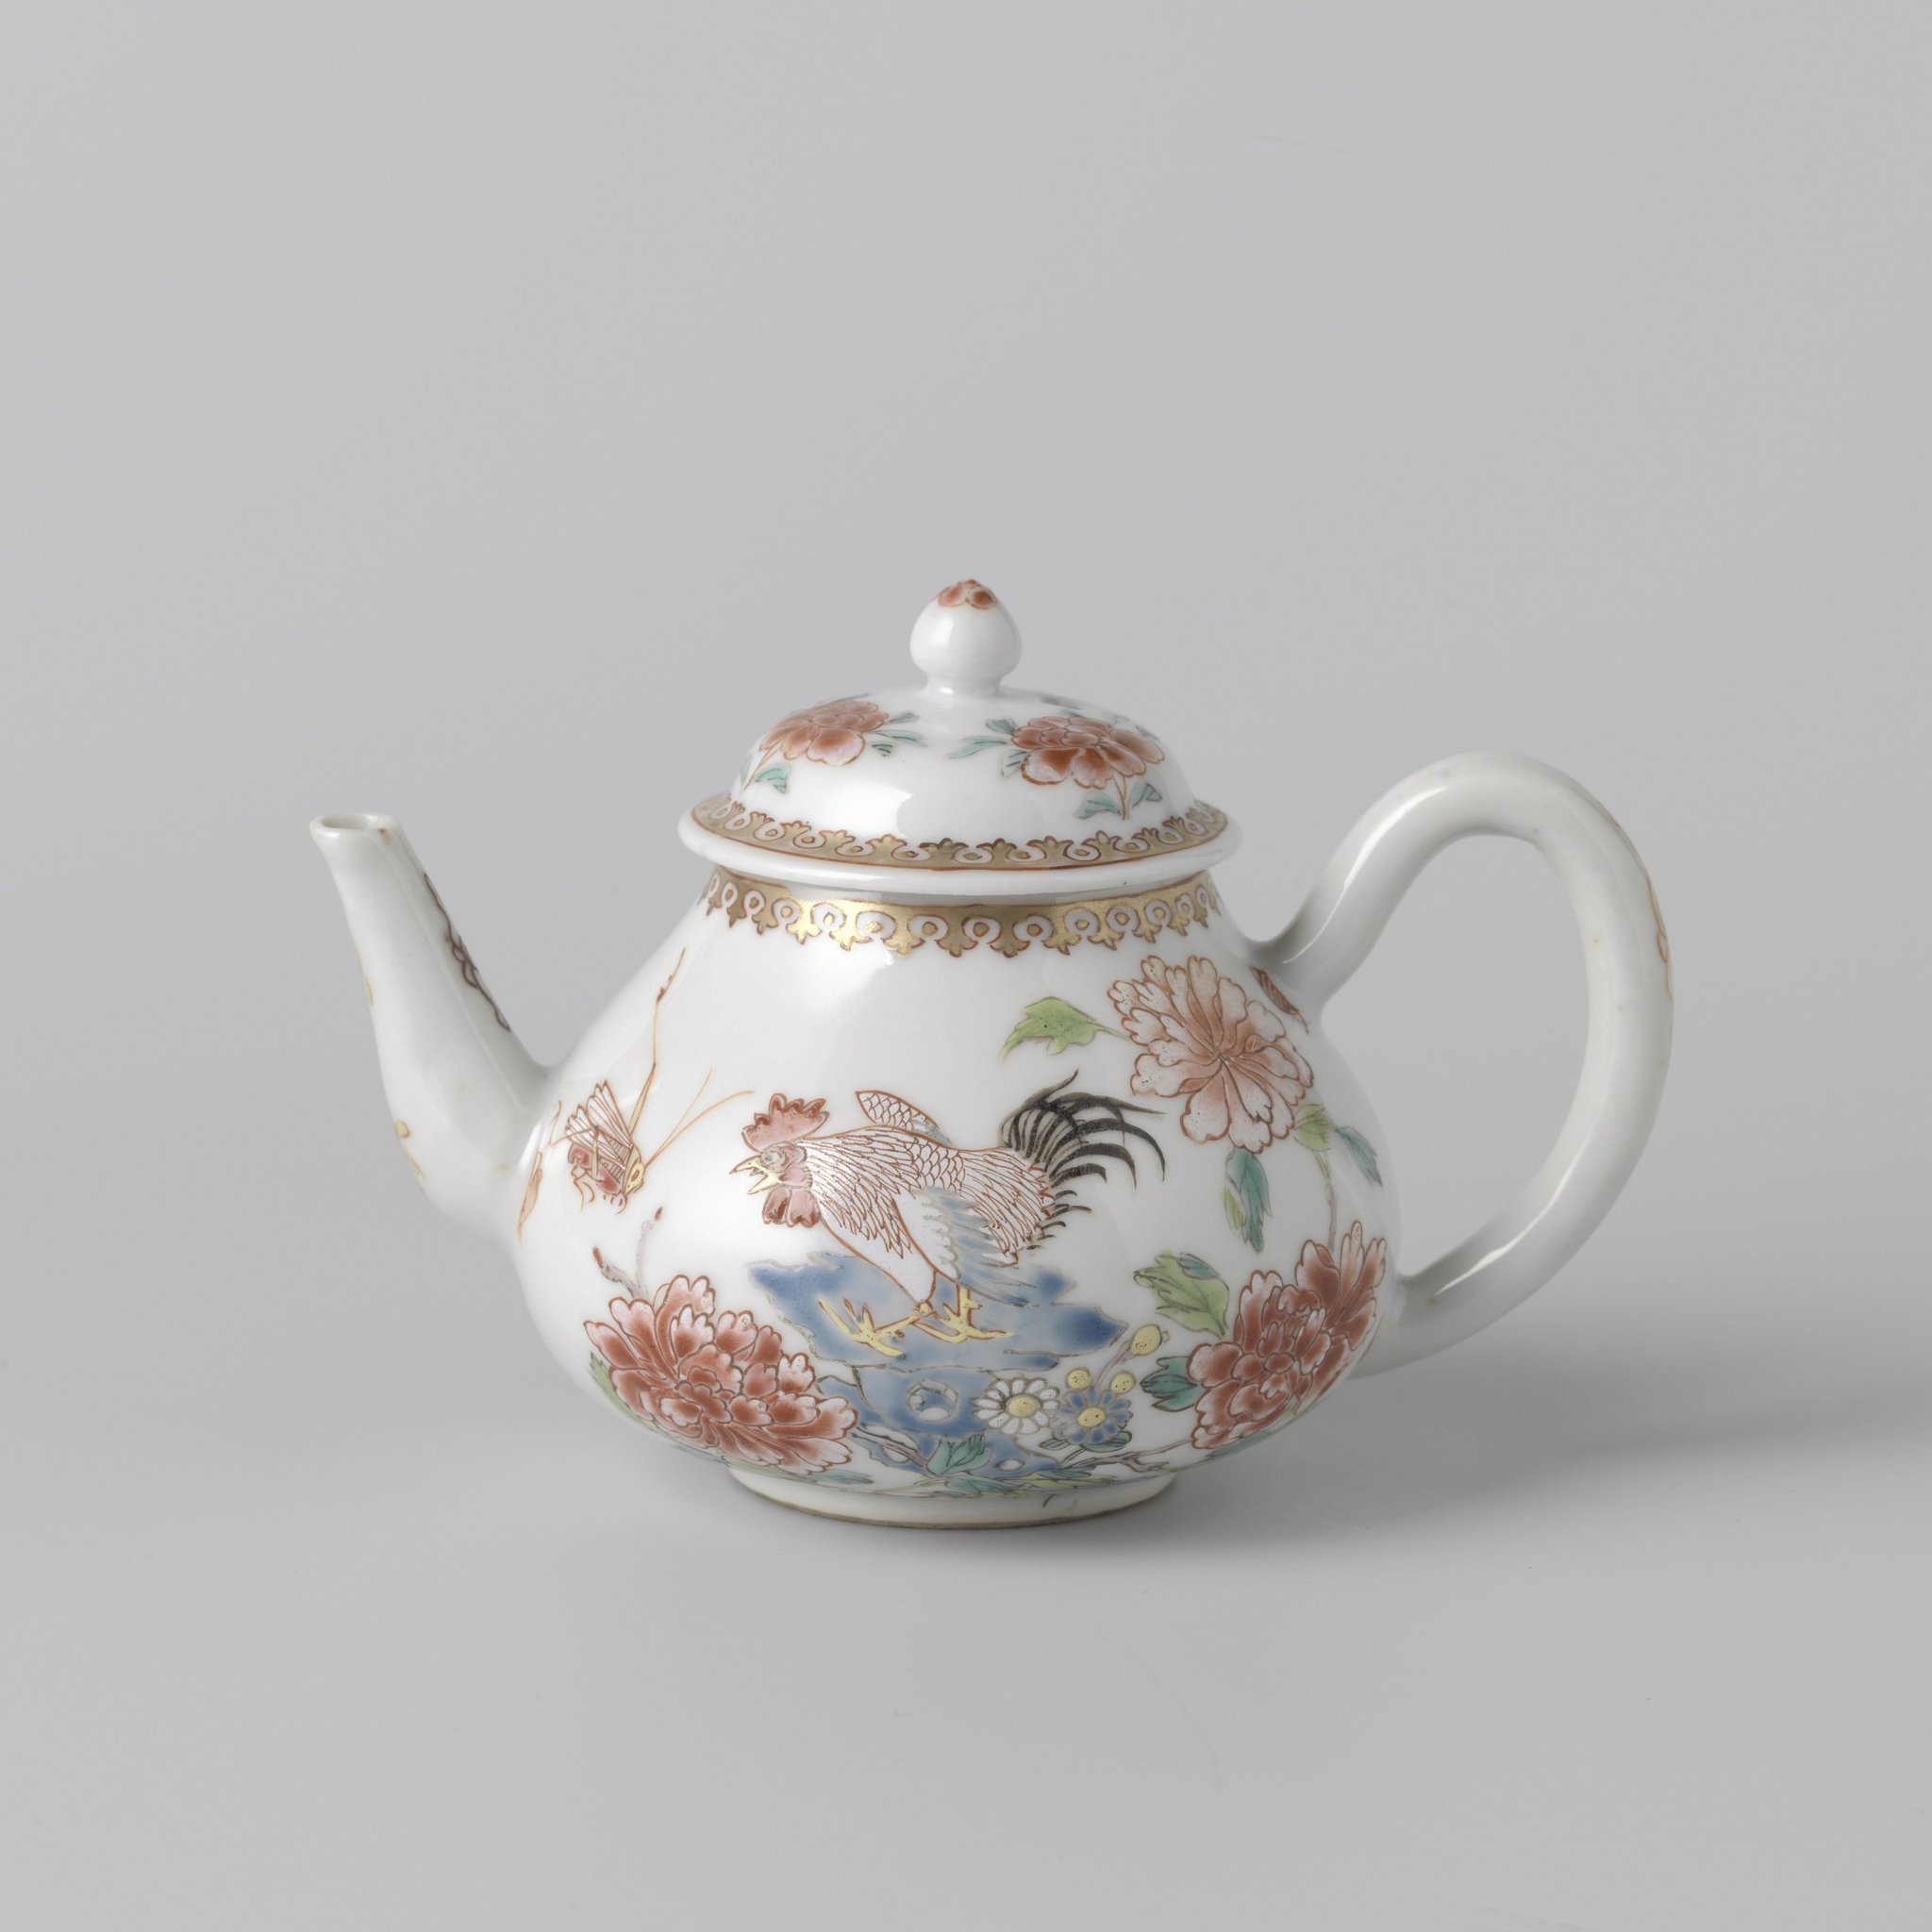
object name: teapot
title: Teapot with a cock on a rock near flowering plants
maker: Anonymous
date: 1725-1749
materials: glaze, gold, paint, porcelain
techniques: firing, gilding, turning, vitrification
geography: china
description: Peervormige theepot van porselein, beschilderd op het glazuur in blauw, rood, groen, geel, zwart en goud. Op de wand tweemaal een haan op een rots bij bloeiende planten (pioen, aster) met daarnaast een insect. Op de rand een 'spearhead-border'. Het oor en de tuit met losse bloemen en een wolkmotief. De deksel met pioentakken en op de rand een 'spearhead-border'. Famille rose.